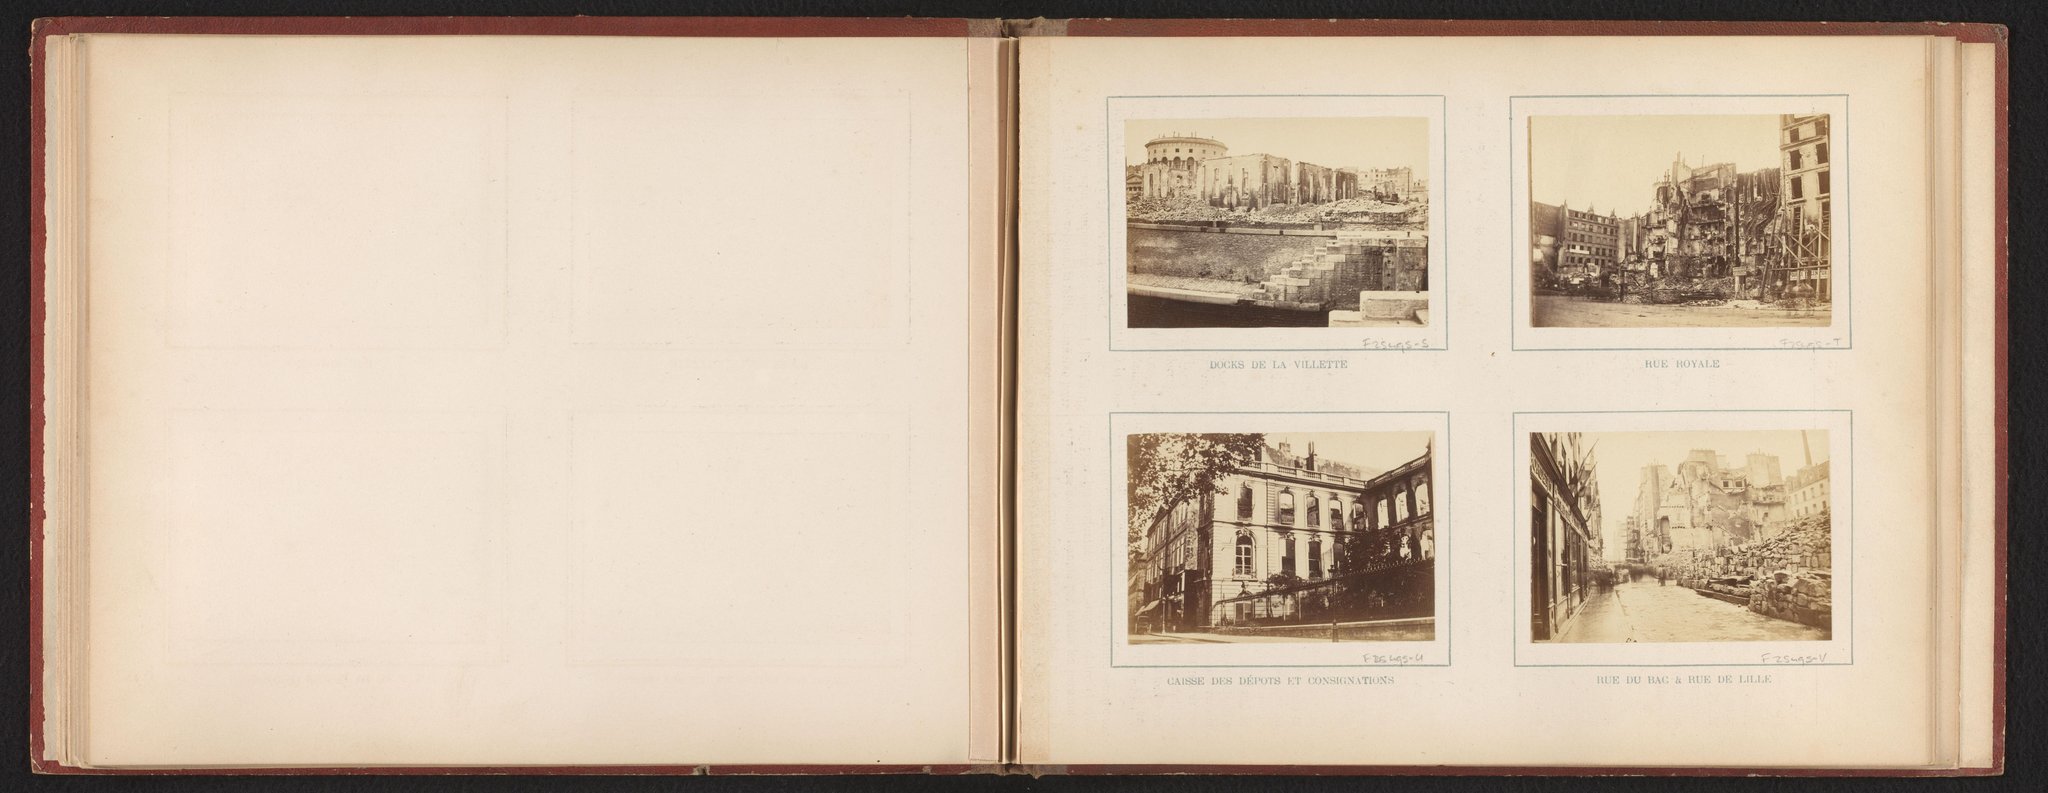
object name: photograph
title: Gezicht op verwoestingen in de rue du Bac en de rue de Lille in Parijs na de semaine sanglante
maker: Anonymous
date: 1871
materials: paper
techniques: albumen print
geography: paris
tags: ruin of a building ~ architecture